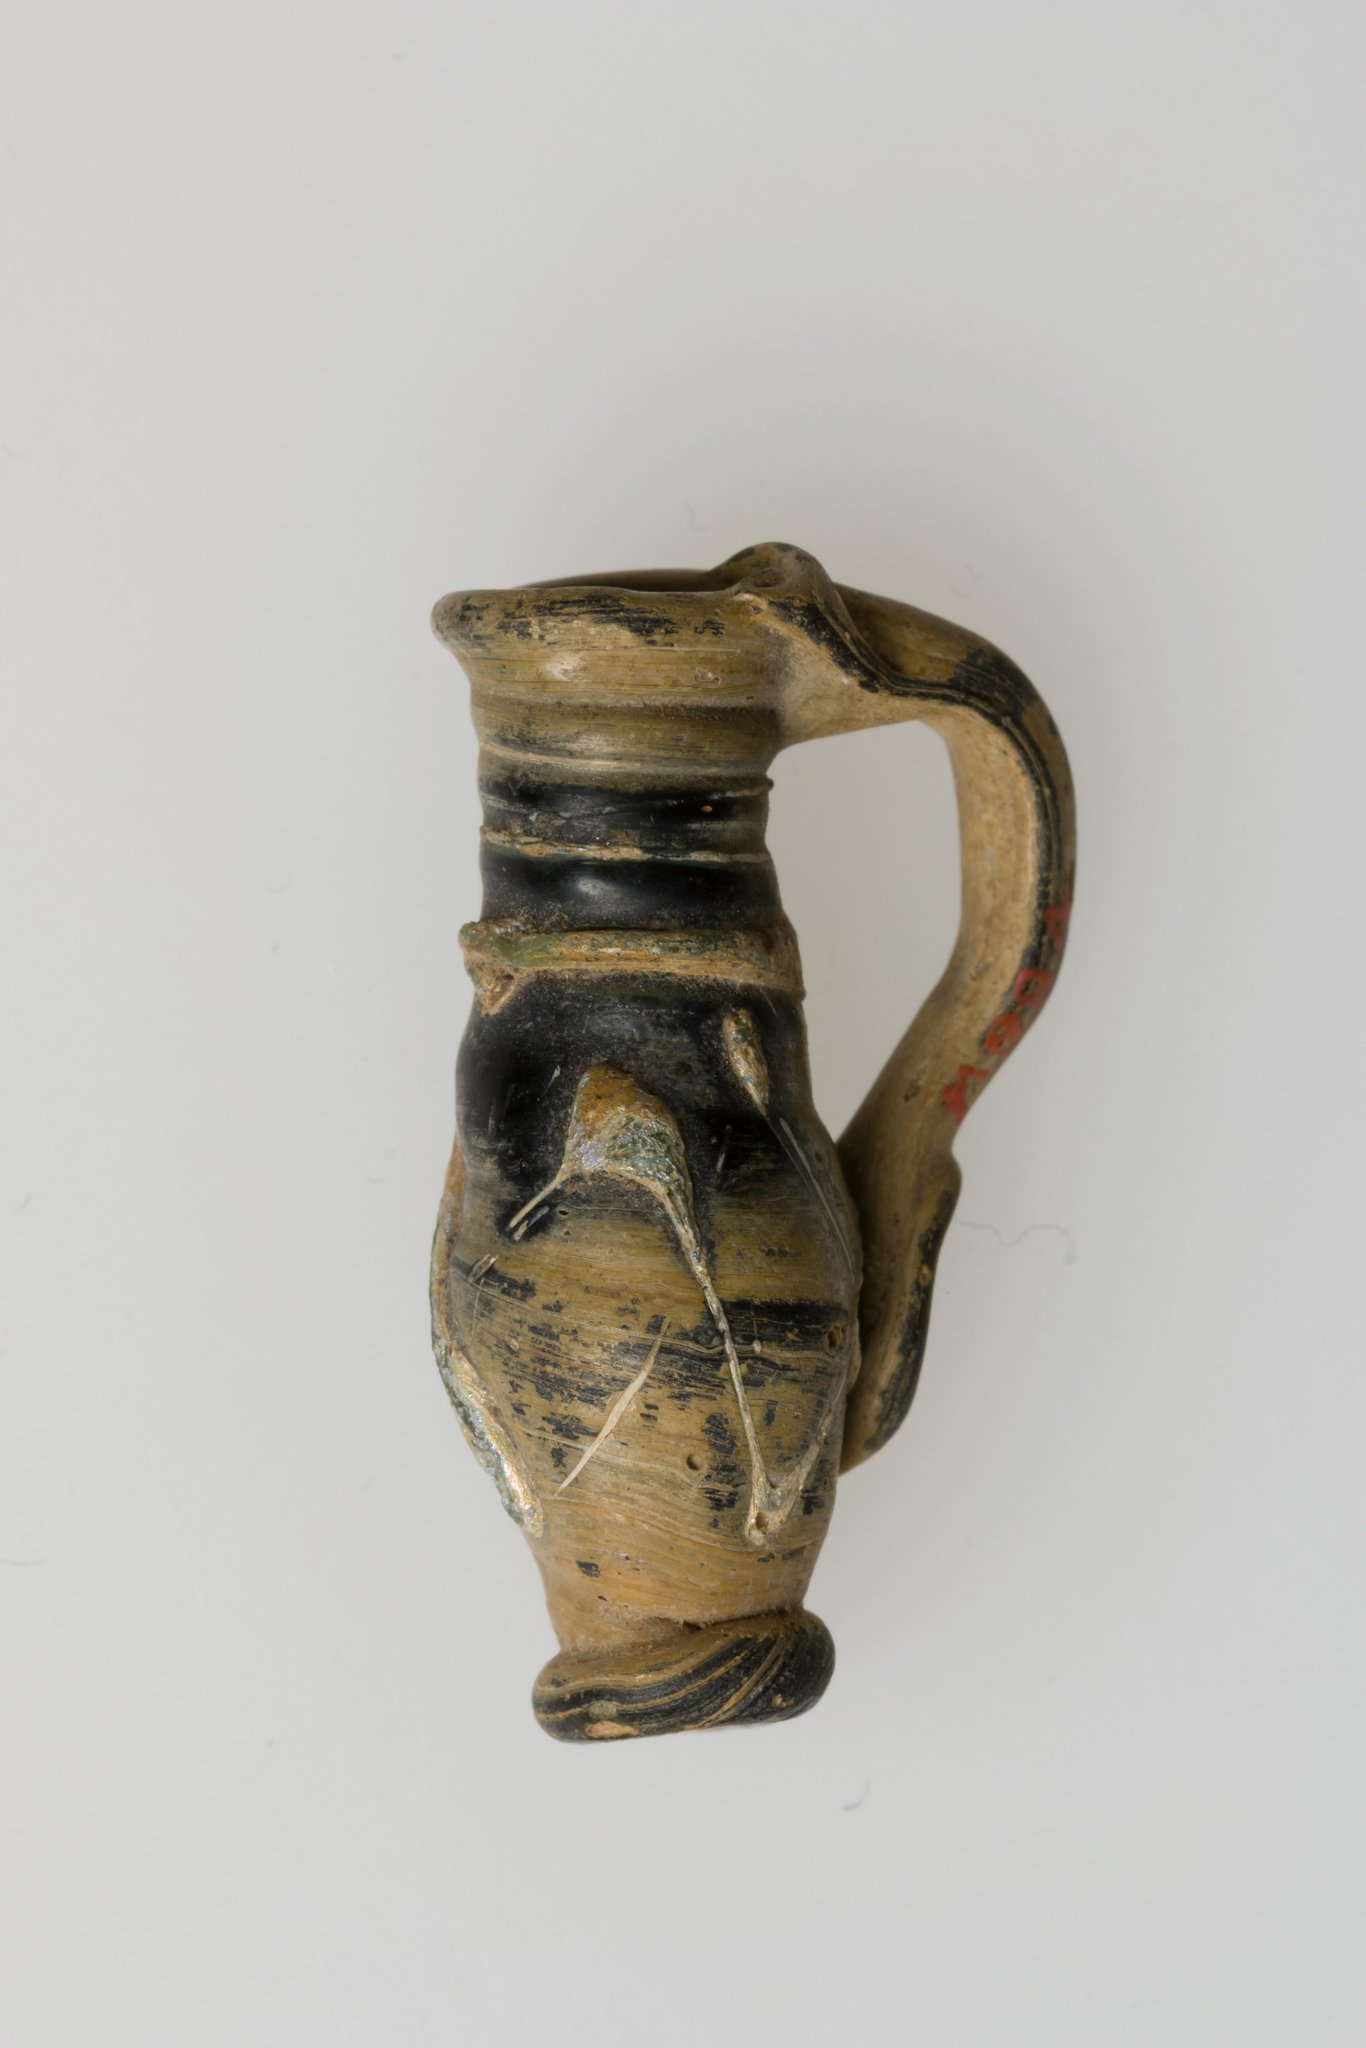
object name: pendant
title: Vase Pendant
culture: egyptian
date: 301-500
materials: glass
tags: vases